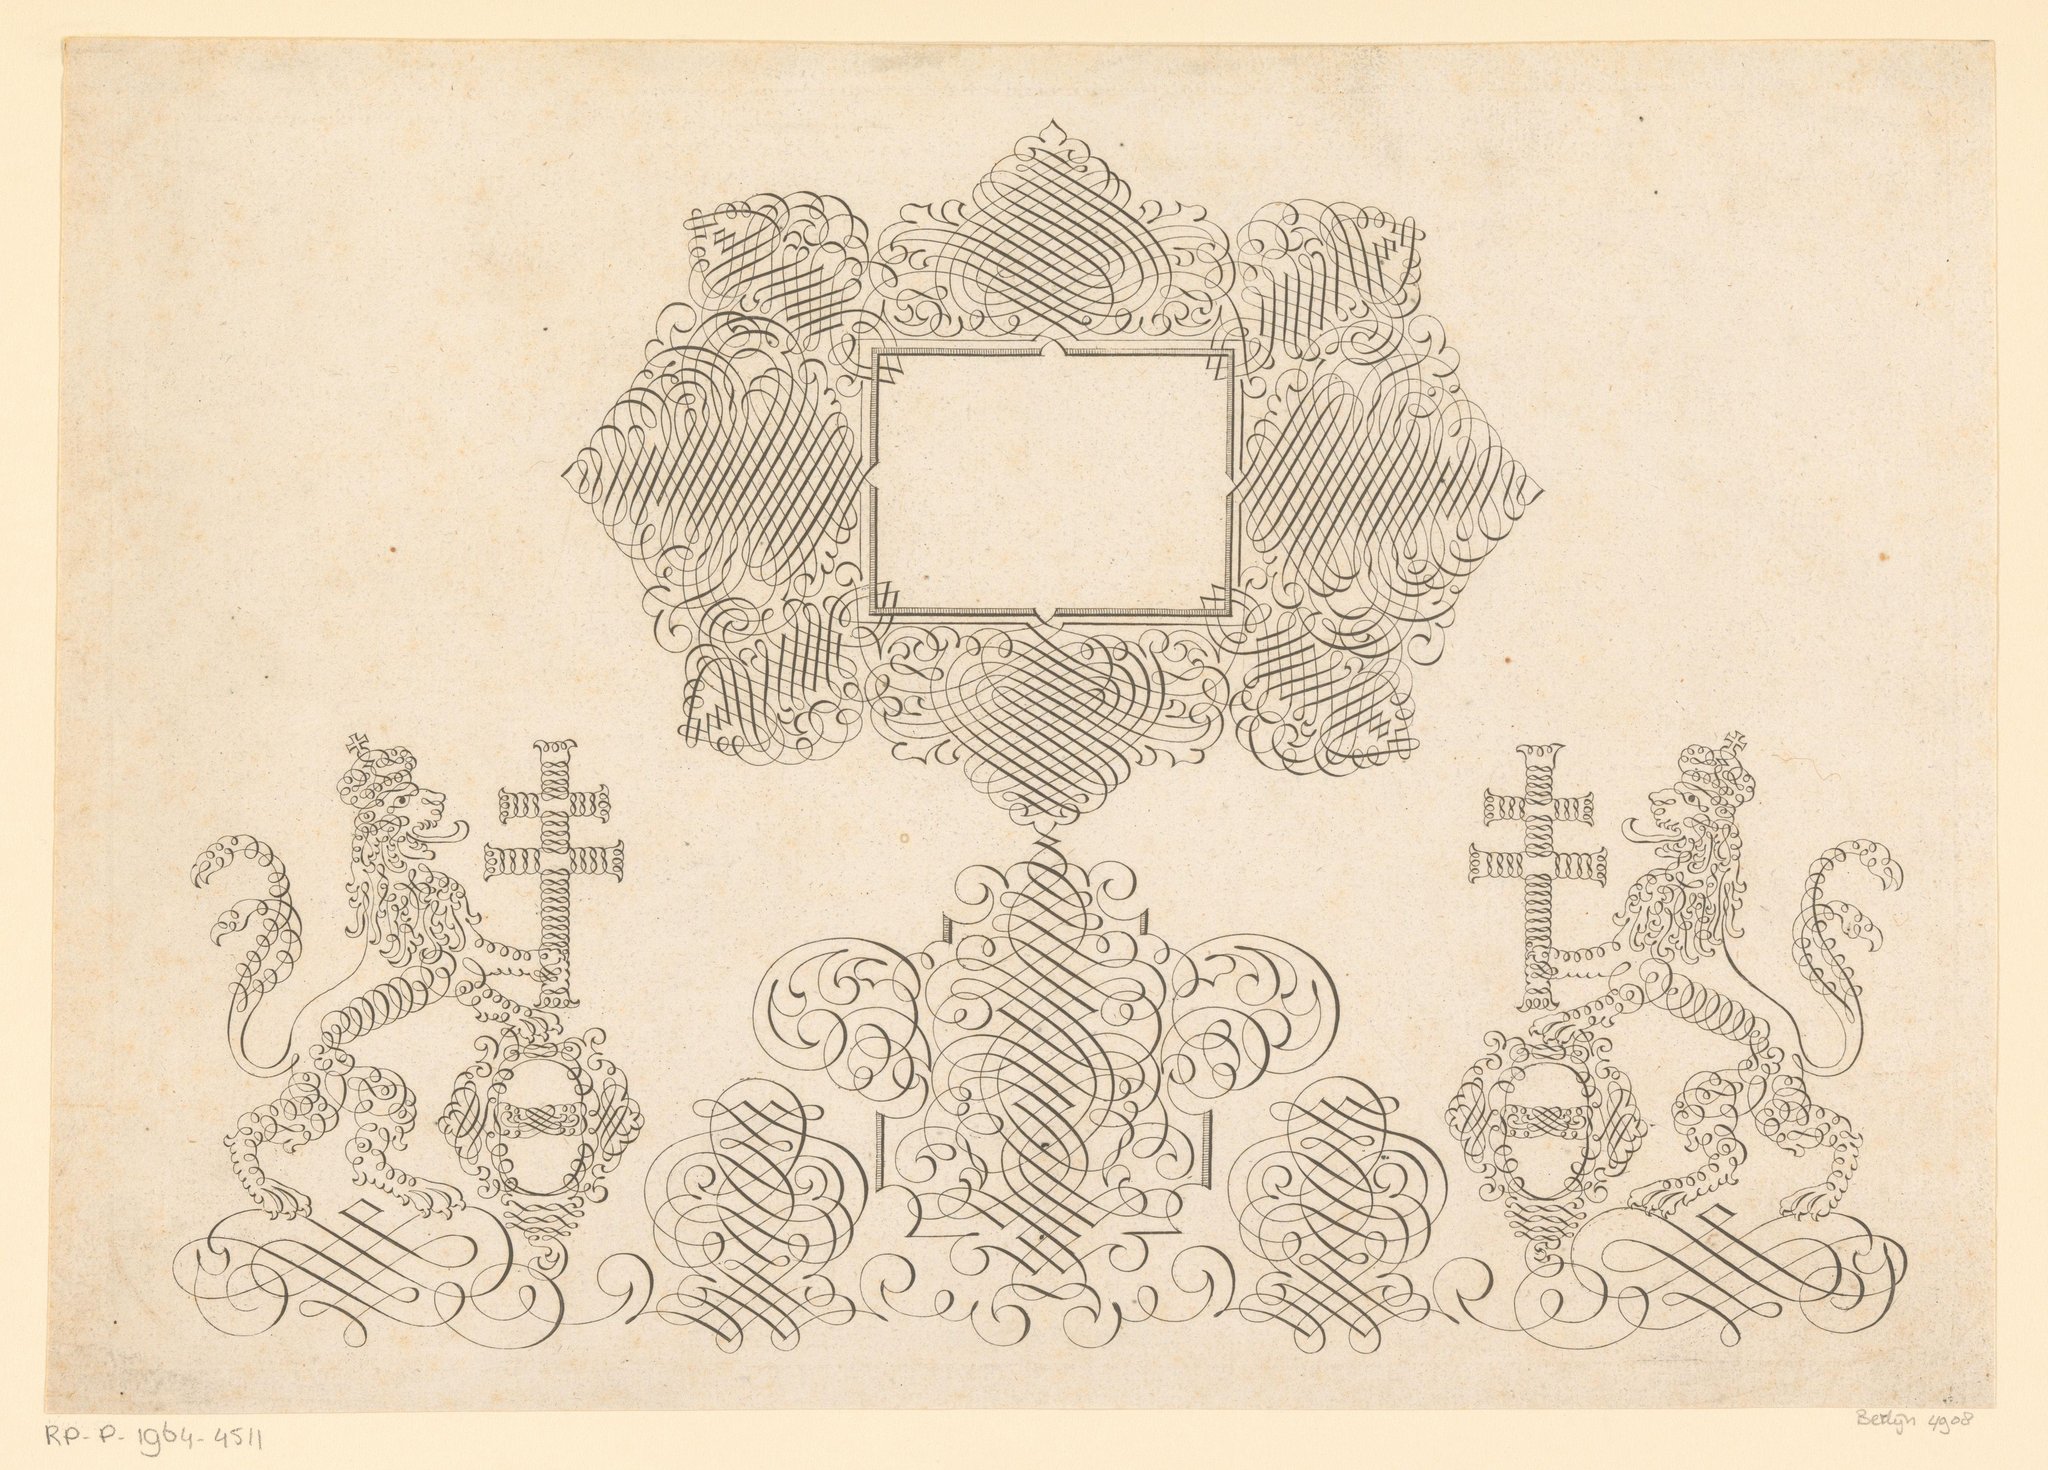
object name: ornament print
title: Vlechtwerk en leeuwen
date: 1756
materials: paper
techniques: engraving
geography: vienna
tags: interlace ~ ornament, beasts of prey, predatory animals: lion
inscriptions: collector's mark: Lugt 2228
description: Rechthoekig ornament van vlechtwerk met aan weerszijden een gekroonde leeuw met dubbelkruis.